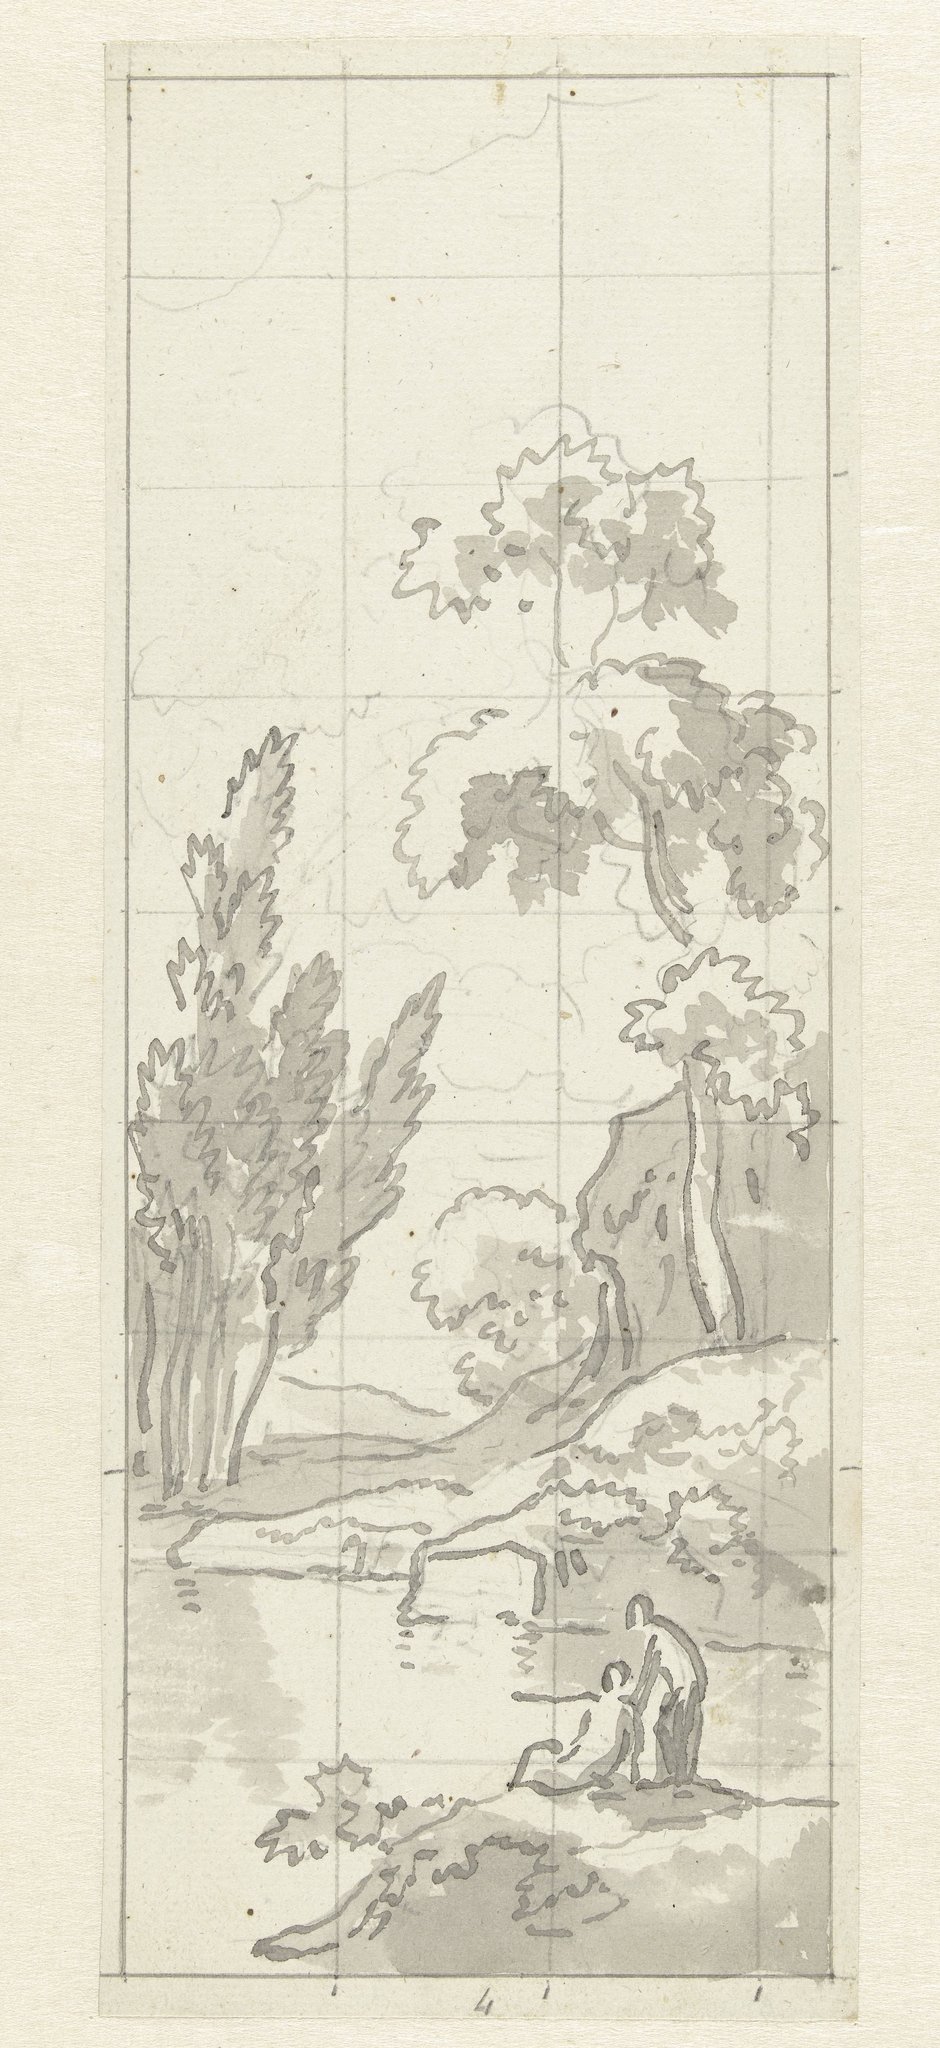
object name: design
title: Ontwerp voor behangselschildering met heuvelachtig landschap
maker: jurriaan andriessen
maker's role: draughtsman, painter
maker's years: 1742-1819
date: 1752-1819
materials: graphite, ink, paper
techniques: brush, pen, drawing